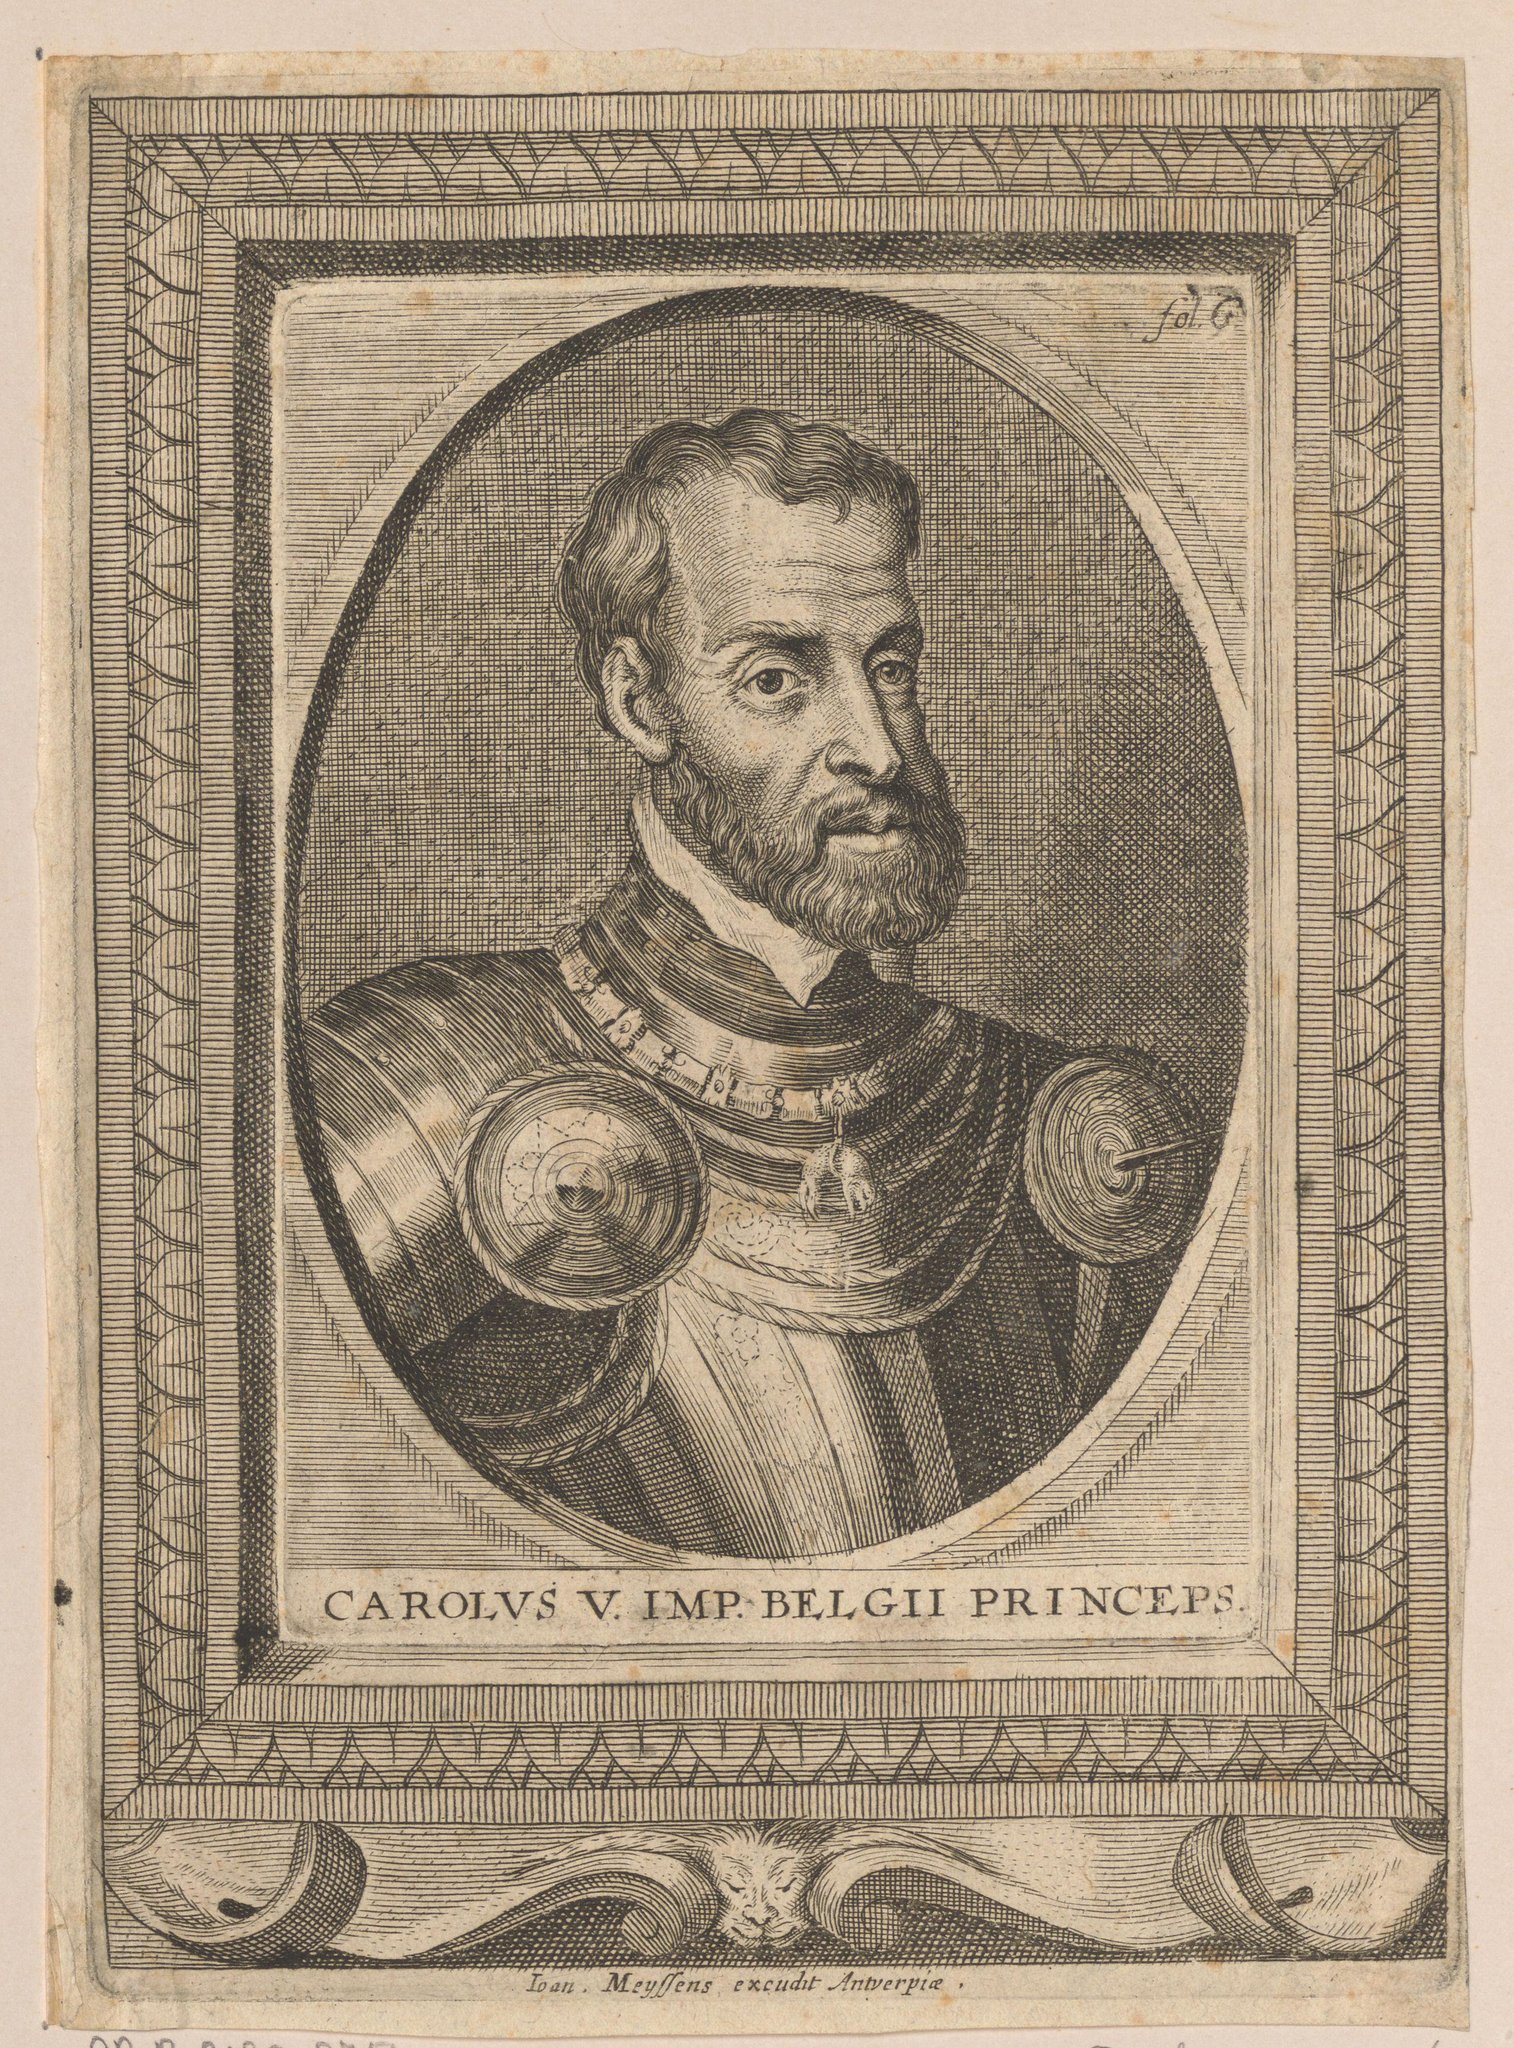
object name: print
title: Portret van keizer Karel V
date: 1640-1670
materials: paper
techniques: engraving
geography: antwerp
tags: ghent, charles v (holy roman emperor and king of spain), historical persons, knighthood order of the golden fleece, king